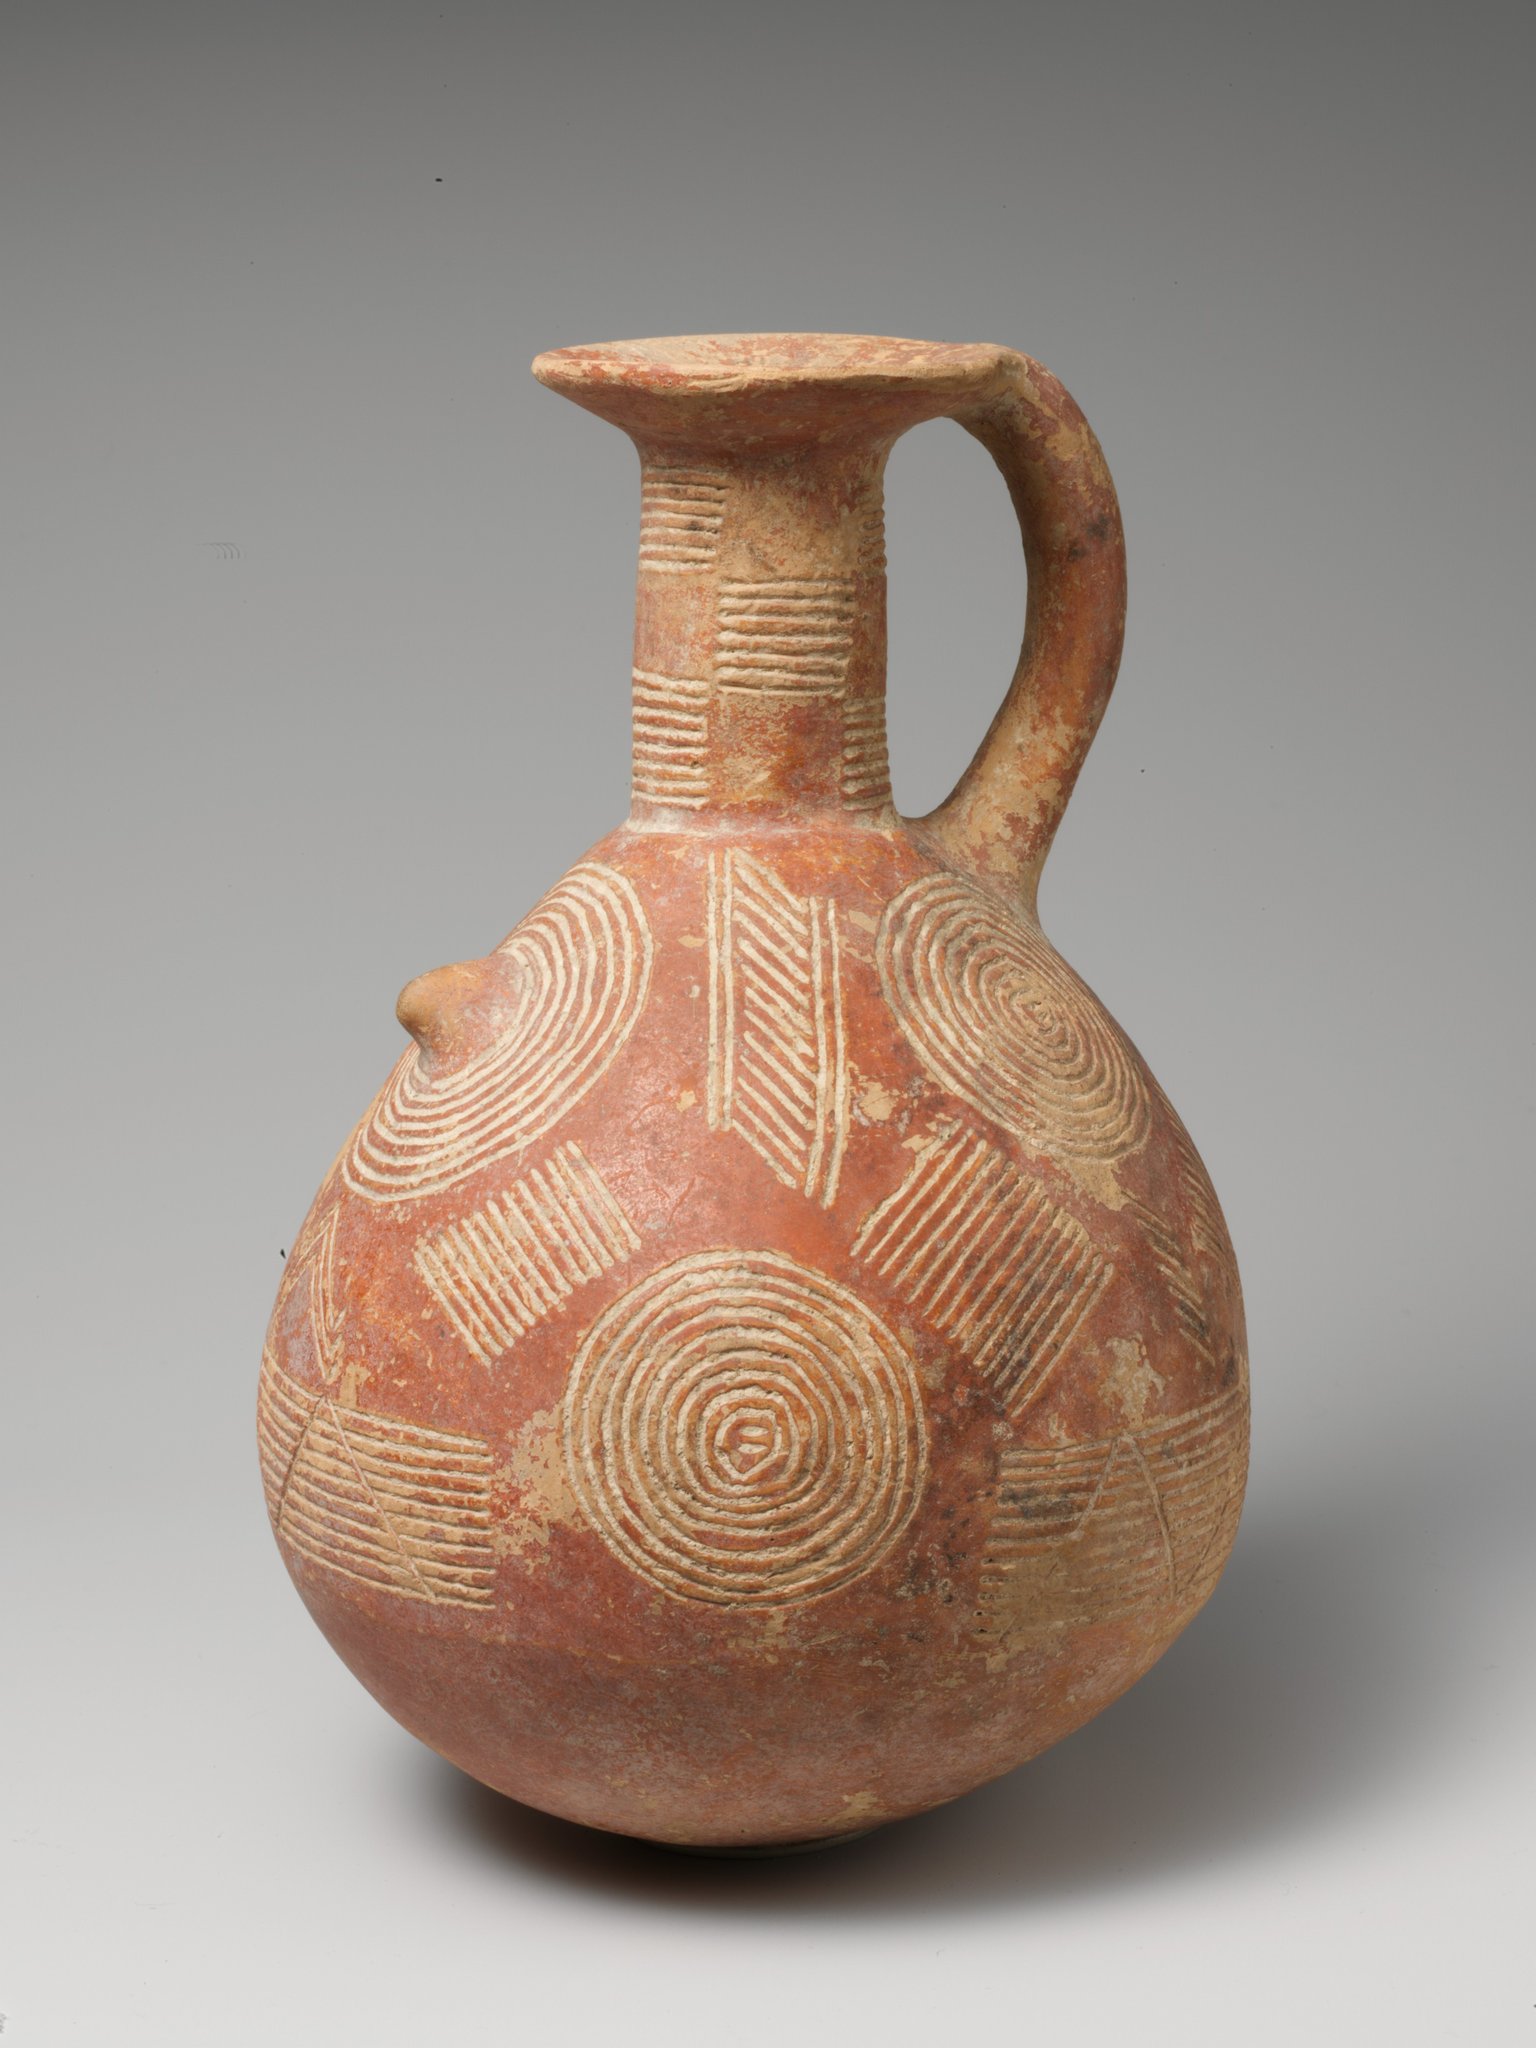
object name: jug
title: Terracotta jug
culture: cypriot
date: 2500-1900 BCE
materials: terracotta